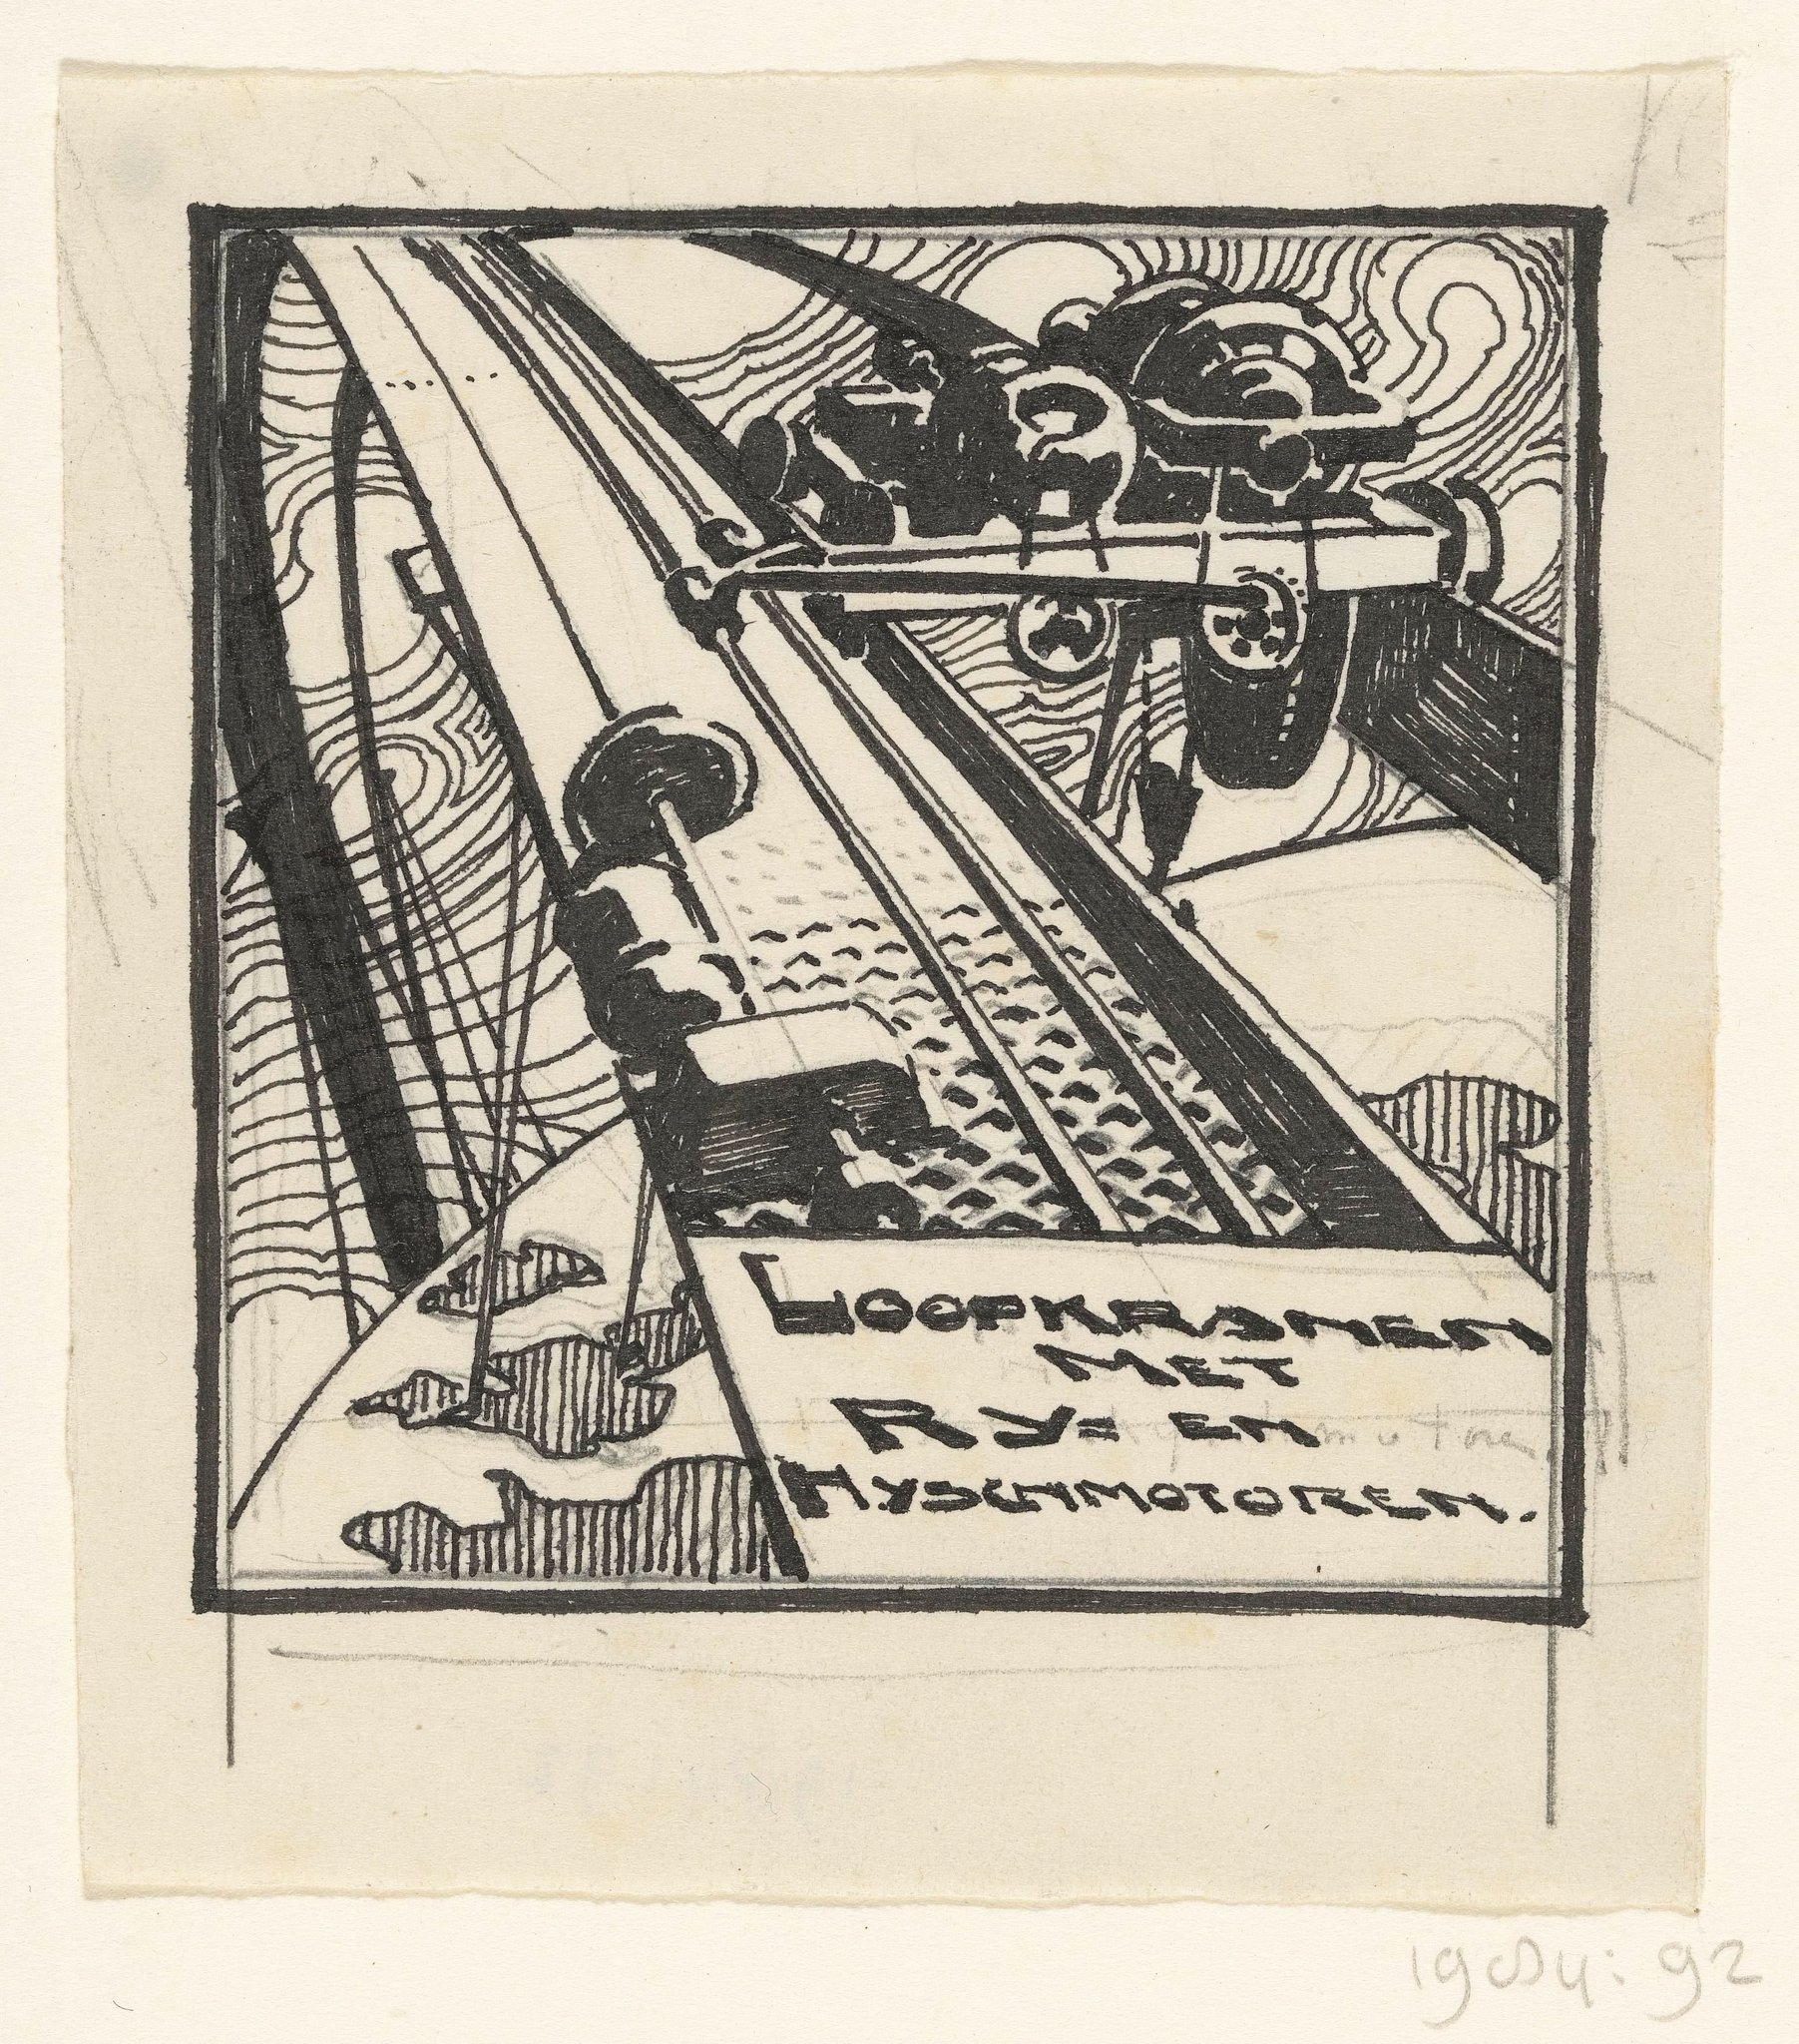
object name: drawing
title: Loopkranen met Ry- en Hyschmotoren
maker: reijer stolk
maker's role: draughtsman, print maker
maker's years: 1896-1945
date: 1906-1945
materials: ink, paper, pencil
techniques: pen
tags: (other) historical names, advertisement, notice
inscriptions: collector's mark: Lugt 2228, collector's mark: Lugt 2228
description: Deze tekening is mogelijk een ontwerp voor een advertentie of affiche.